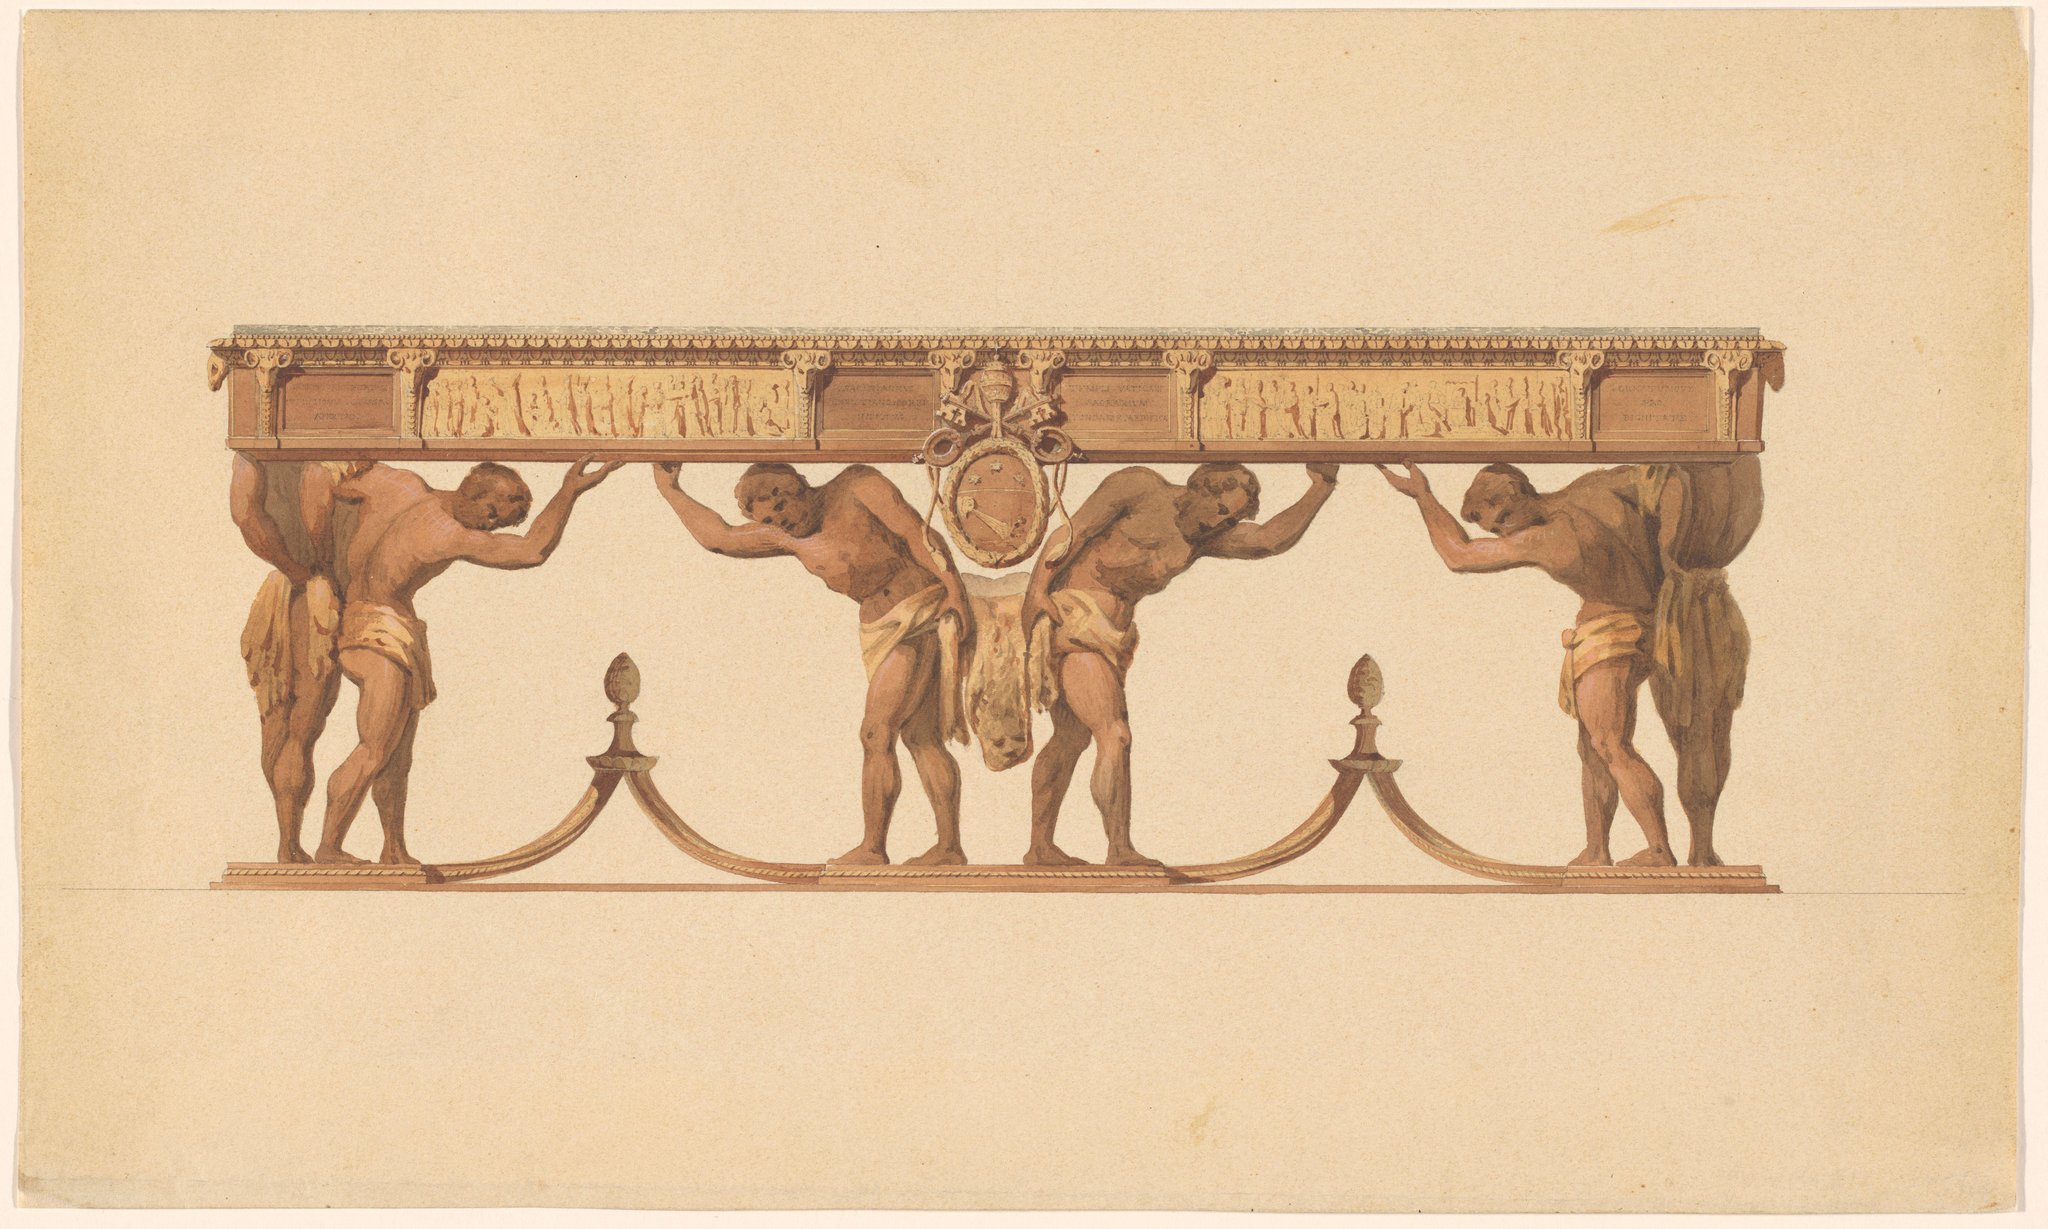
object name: drawing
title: Een van de twee bronzen tafels die Giuseppe Valadier in 1792 aan paus Pius VI heeft geleverd voor de bibliotheek van het Vaticaan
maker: christoph unterberger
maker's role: draughtsman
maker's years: 1732-1798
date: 1791-1792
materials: graphite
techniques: brush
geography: rome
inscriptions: inscription: ‘SAN[...] PORTAE / [...]CAVSSA. / APERTO; SACER.ANNVS / [...[IANI NOR 31 / INDVCTVS; TEMPLI VATICANI / SACRARIVM / FVNDAMA A[..}INFICA / ORNATVMQVE / PRO / DIGNITATE’, coat of arms: ‘het wapen Braschi onder de pauselijke tiara en de gekruiste sleutels van Petrus, voor Paus Pius VI.’